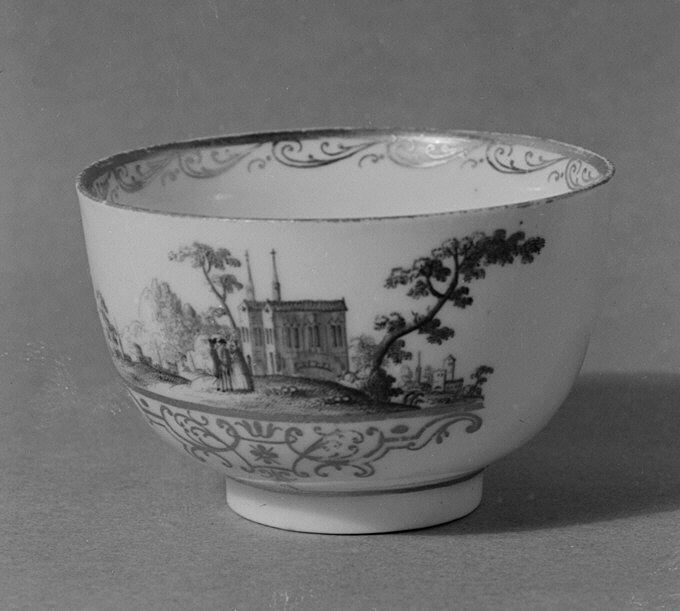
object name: cup and saucer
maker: imperial porcelain manufactory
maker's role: manufactory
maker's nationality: austrian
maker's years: 1744-1864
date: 1750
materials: hard paste porcelain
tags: human figures,buildings